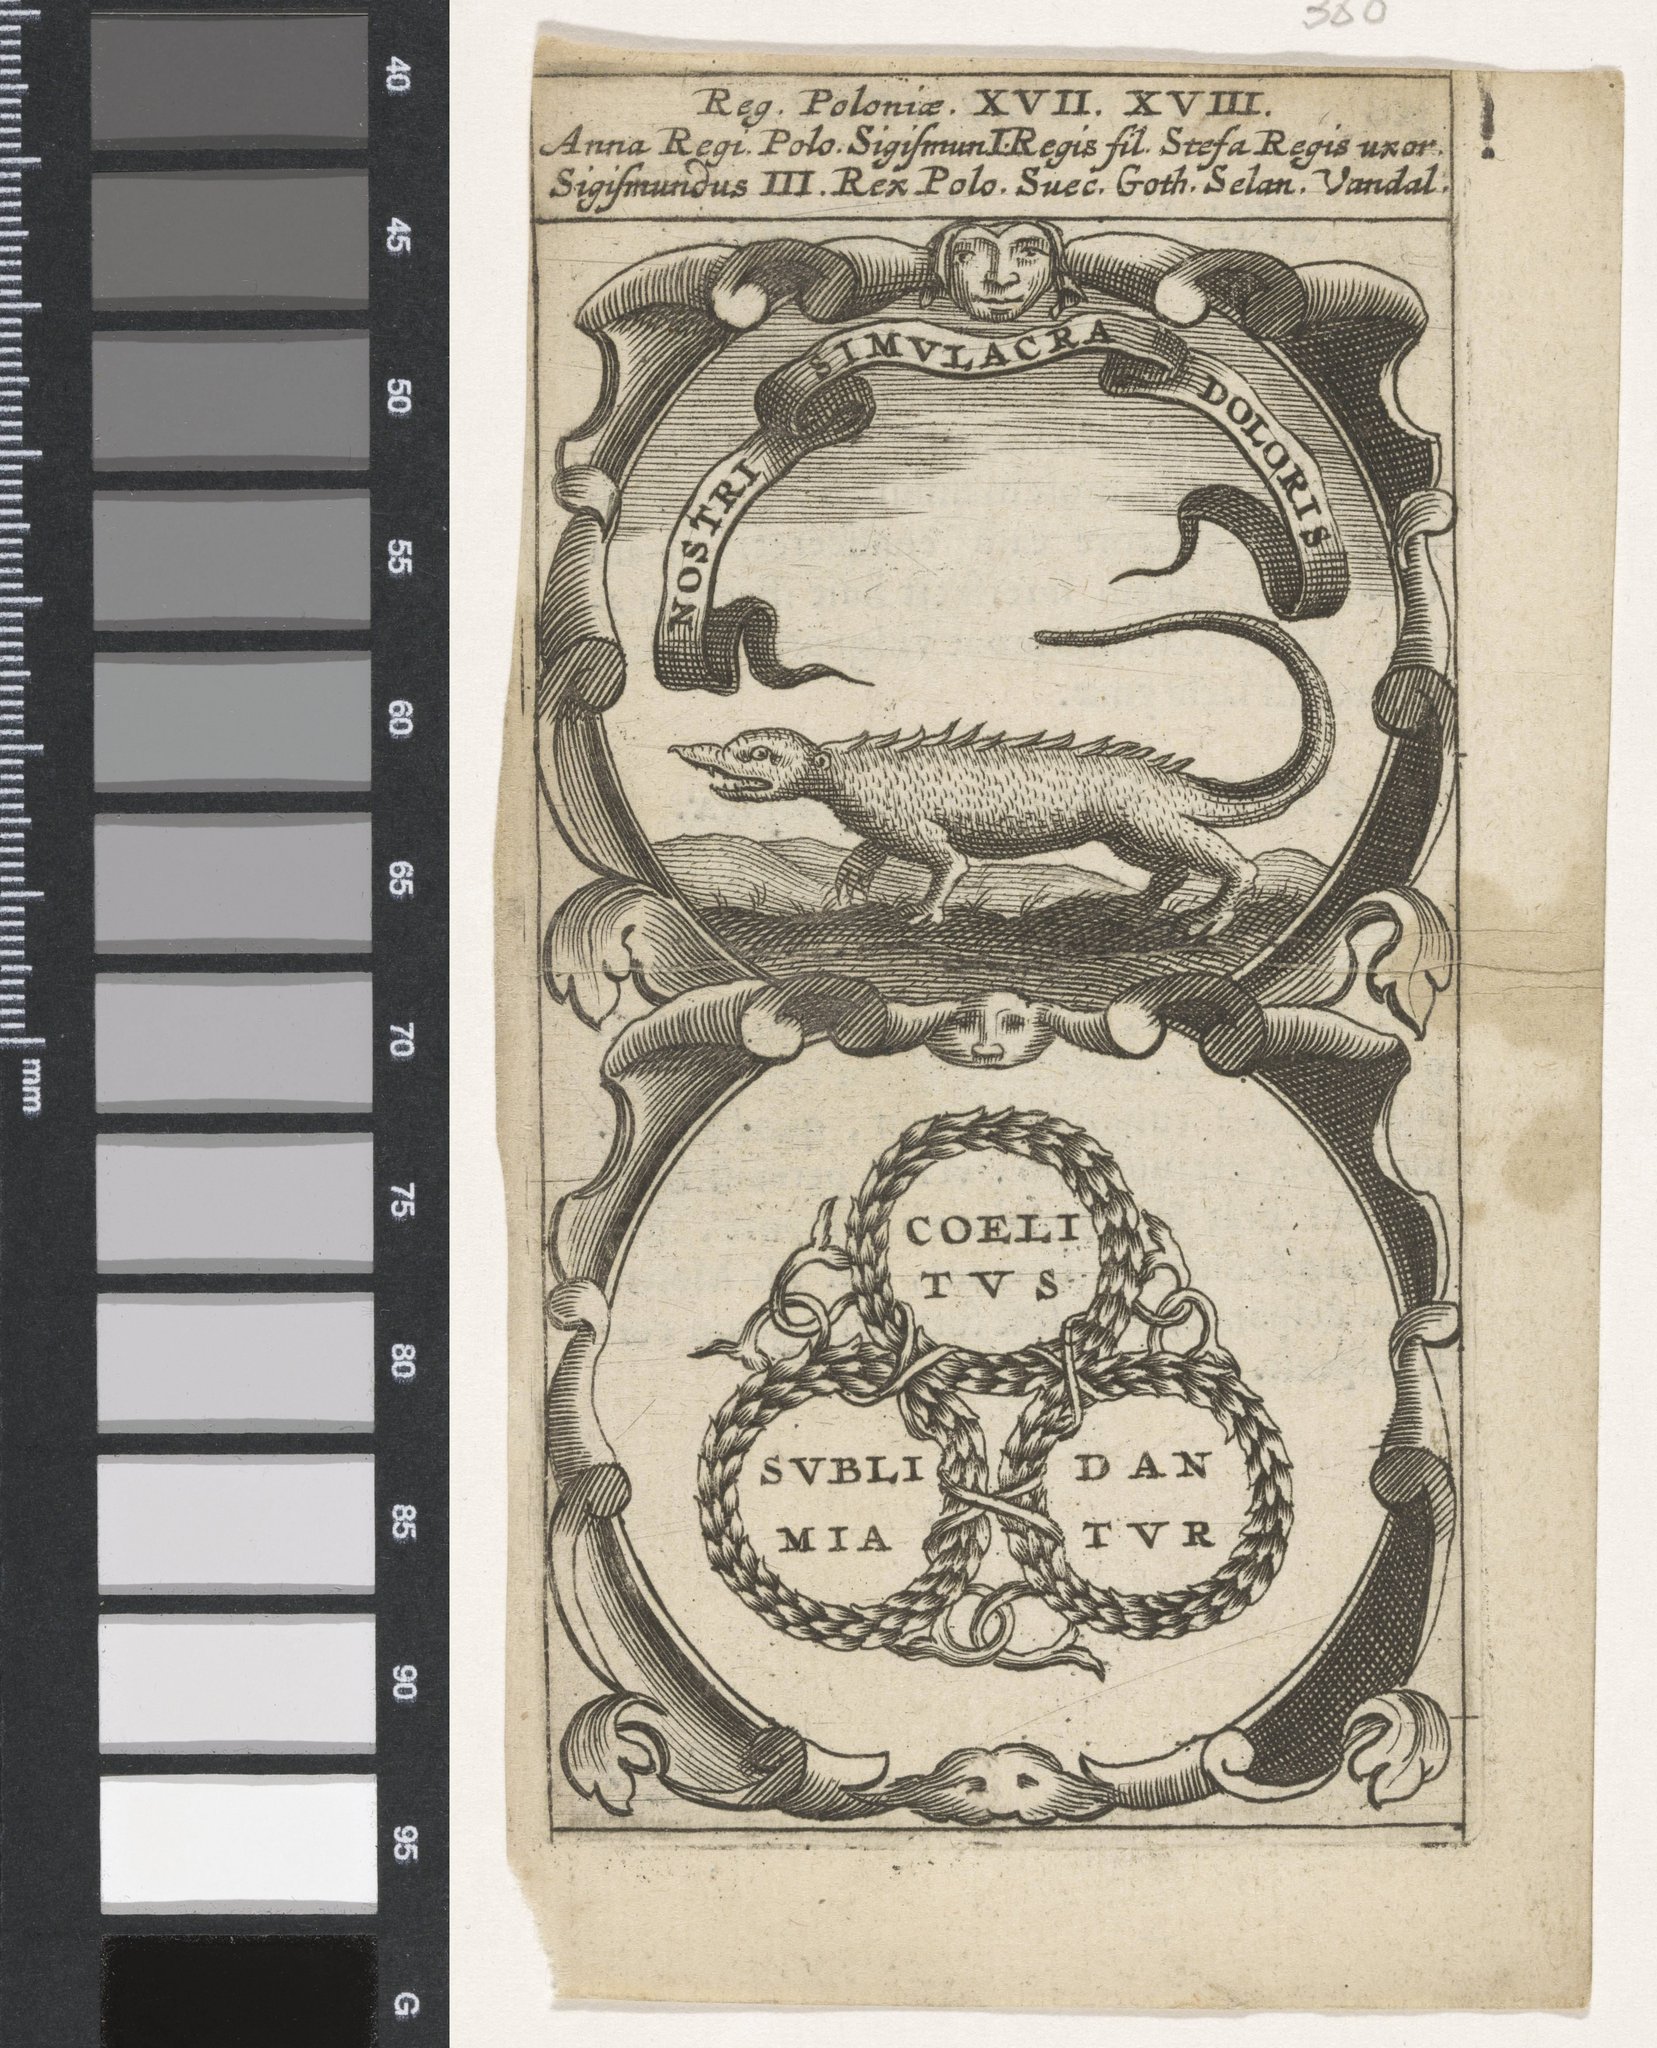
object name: print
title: Nostri Simulacra Doloris / Coelitus Sublimia Dantur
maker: Anonymous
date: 1666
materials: paper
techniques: engraving, letterpress printing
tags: sigismund iii (koning van polen), garland, wreath, crocodiles: crocodile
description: Pagina uit Jacob Typotius, Symbola Divina & Humana Pontificum Imperatorum Regum. Arnhem, J.F. Hagen, 1666 of uit de titeluitgave van 1669 of 1679. Het werk van Typotius werd voor het eerst uitgegeven in 1601 met prenten van Aegidius Sadeler.